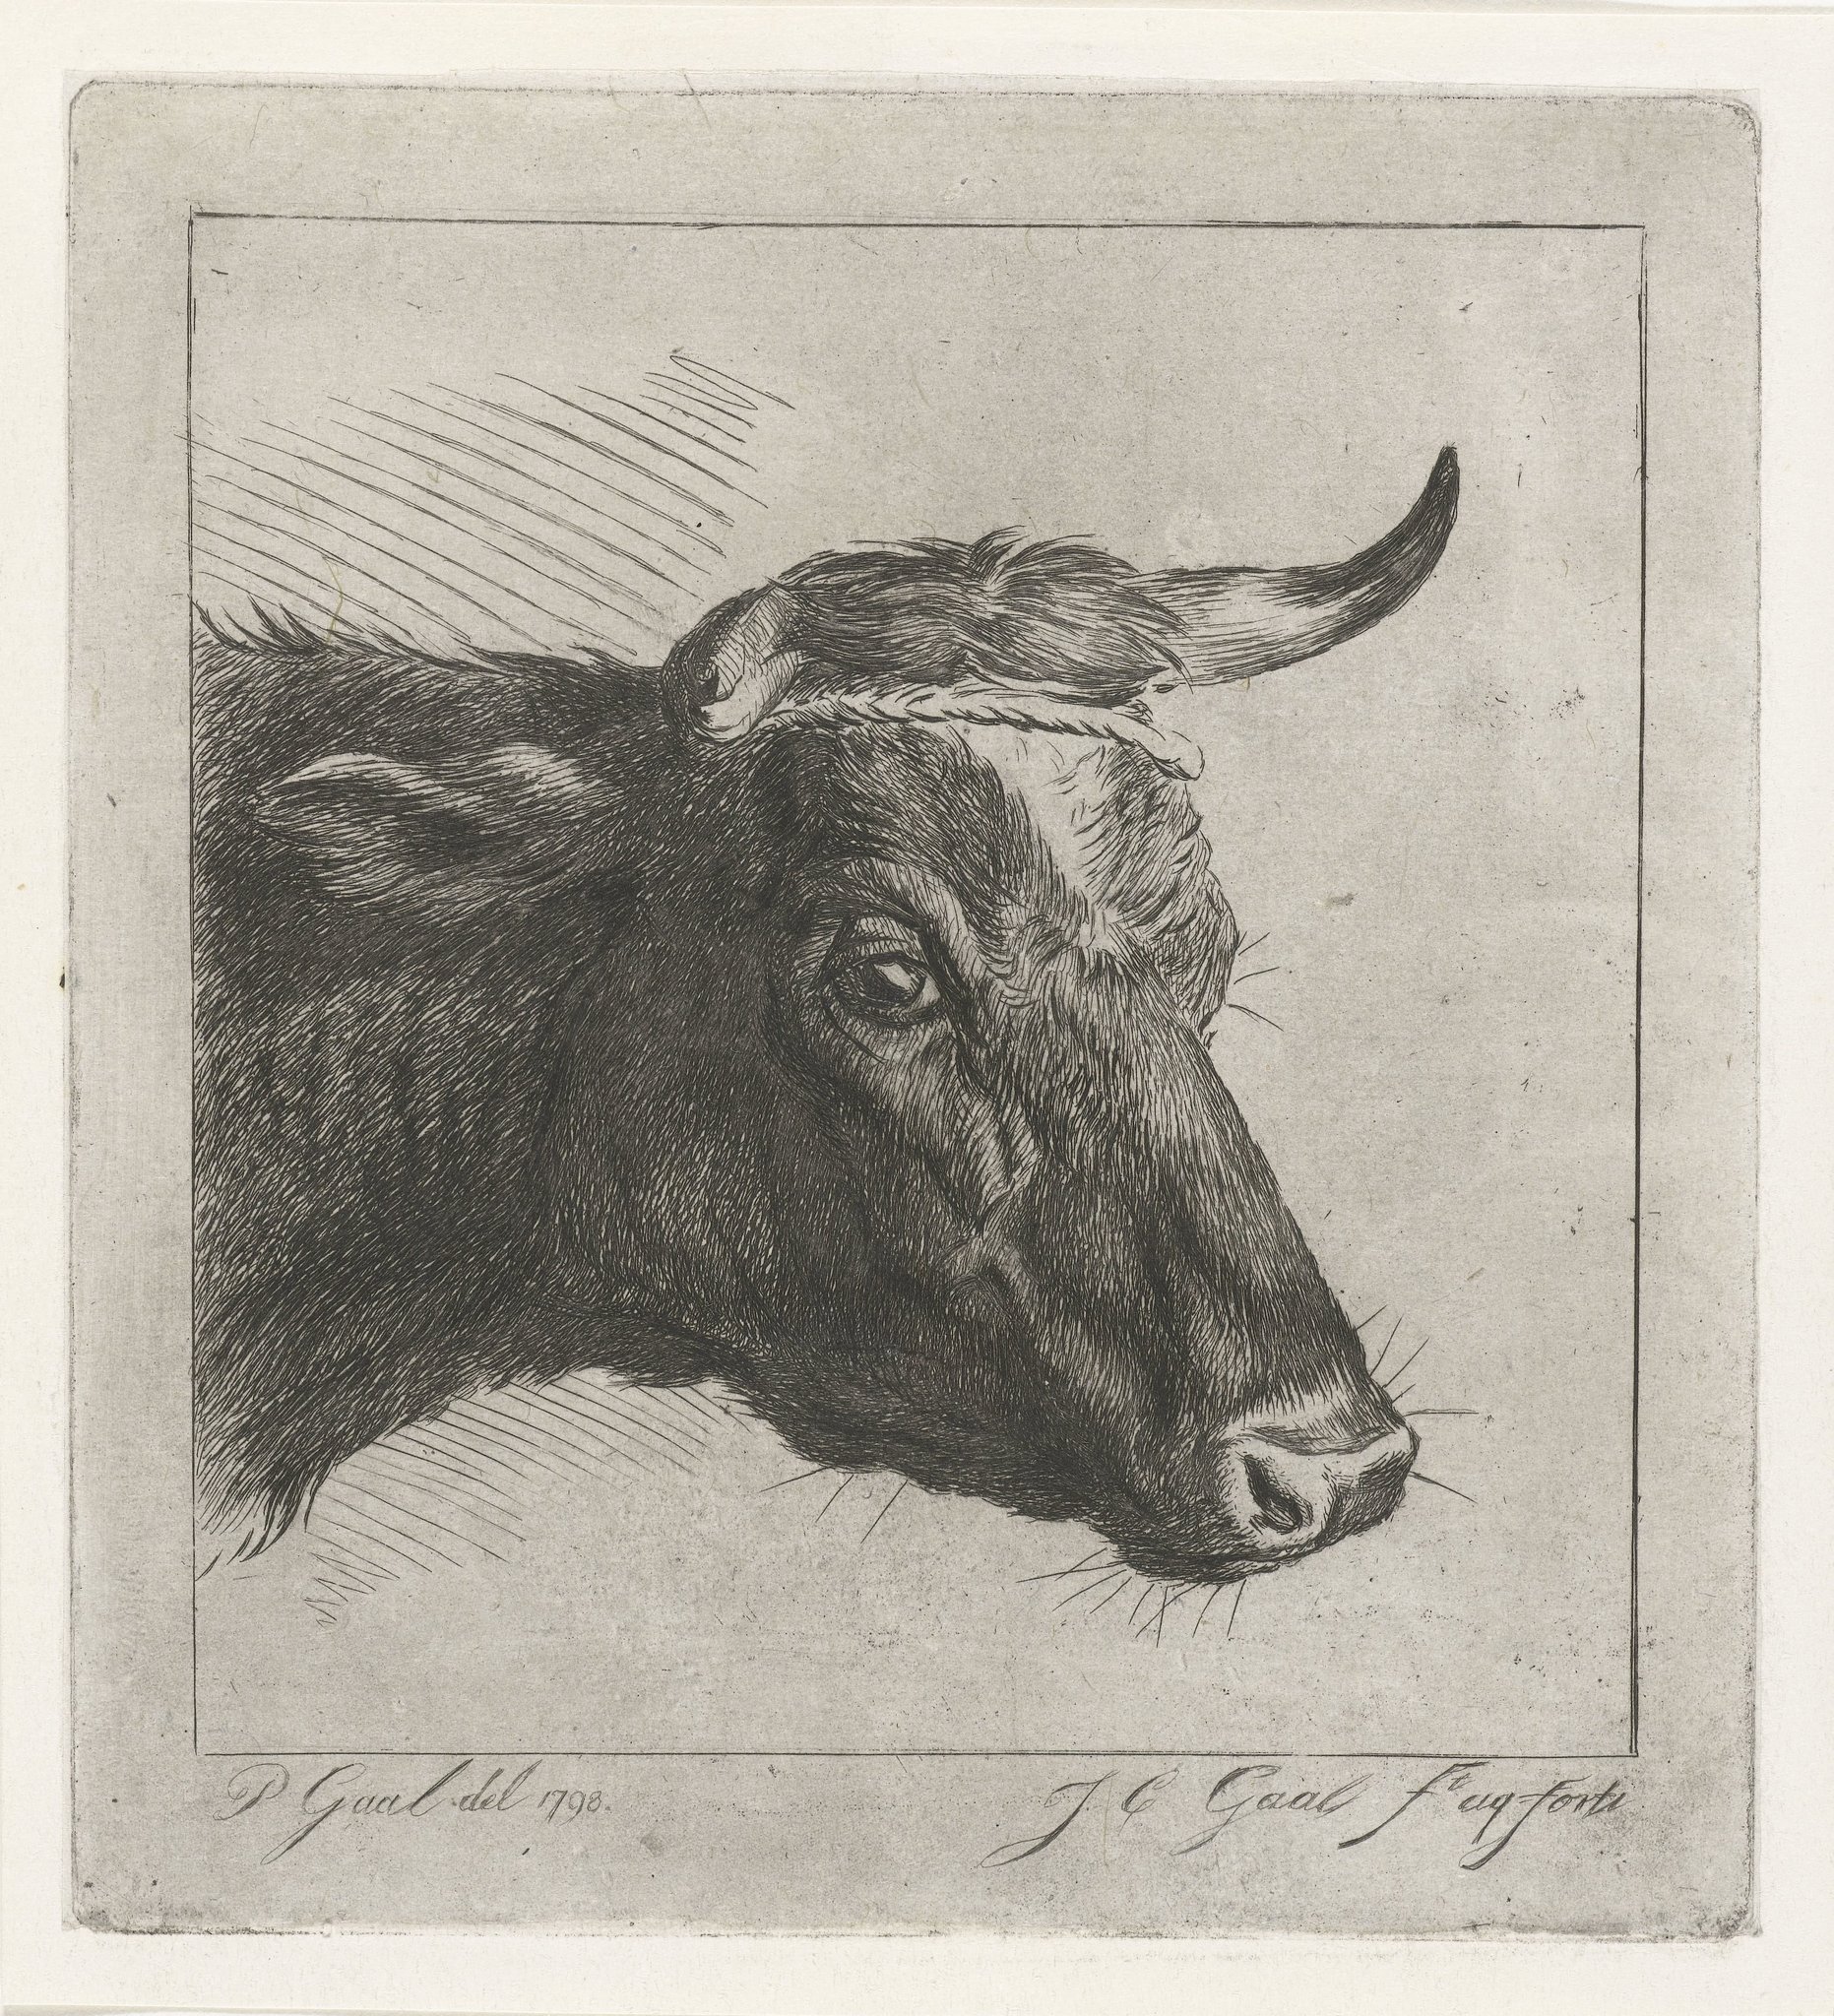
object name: print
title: Kop van een koe met touw om de horens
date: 1854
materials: paper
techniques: etching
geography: netherlands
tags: cow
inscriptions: collector's mark: Lugt 2228